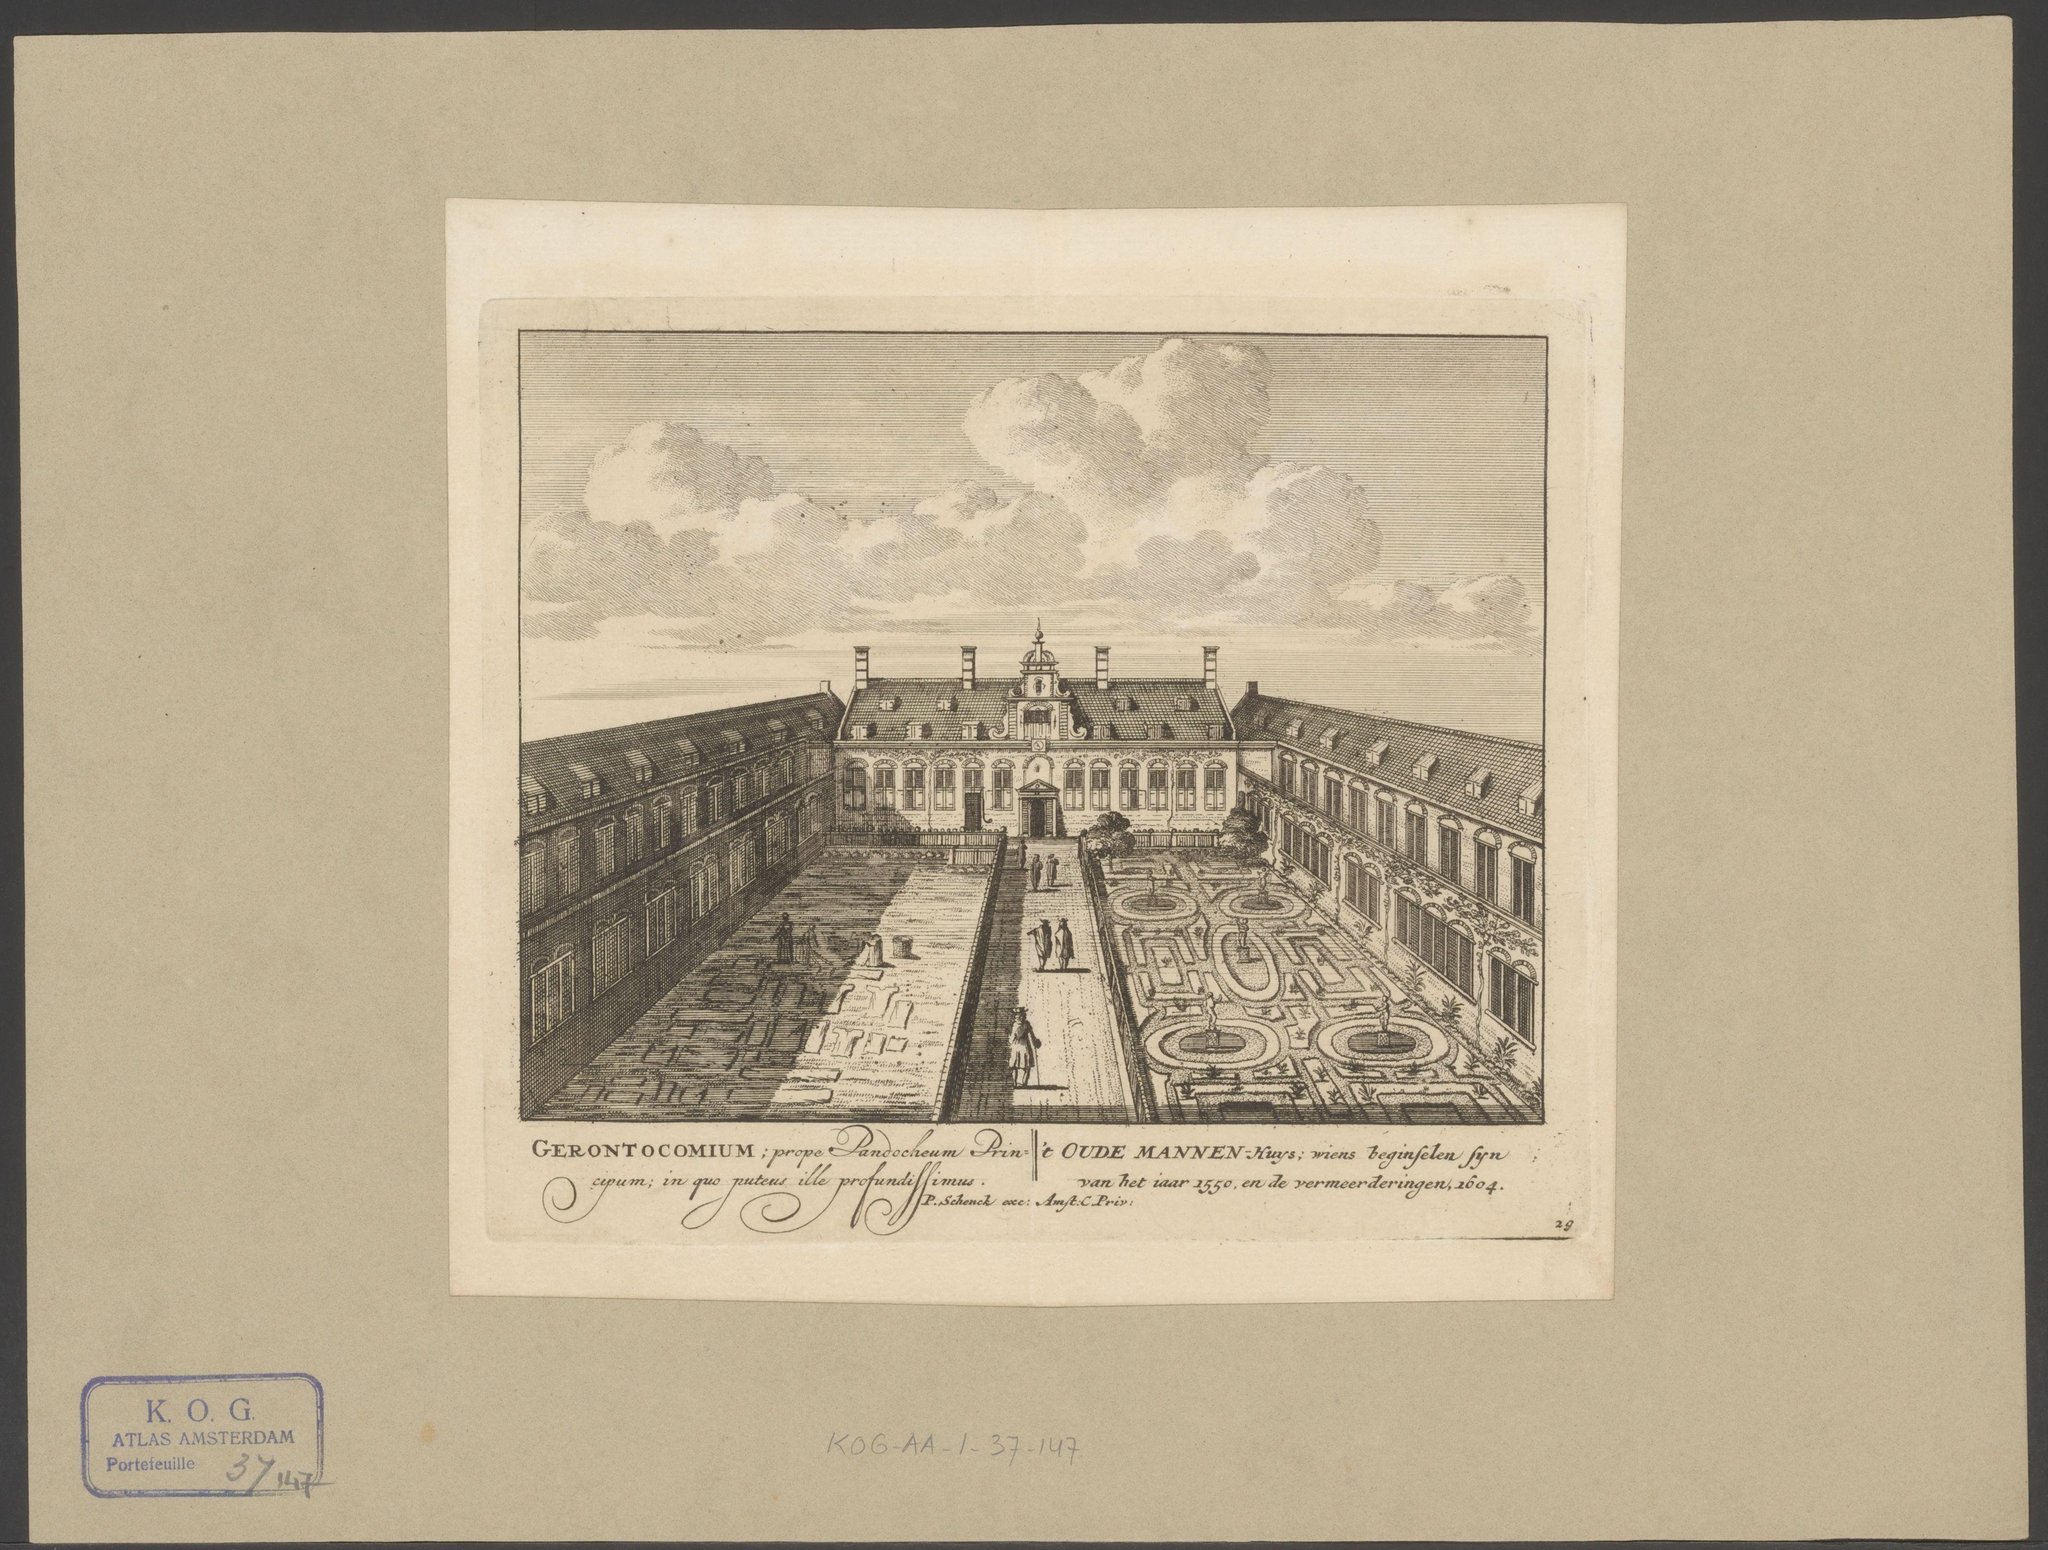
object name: print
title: Gerontocomium; prope Pandocheum Principum in quo putens ille profundissimus / 't Oude Mannen-Huys; wiens beginselen zyn van het jaar 1550, en de vermeerderingen 1604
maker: Anonymous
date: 1710-1711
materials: paper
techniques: engraving, etching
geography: northern netherlands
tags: courtyard, old-people's home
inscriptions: collector's mark: Lugt 1641b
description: Prent mogelijk uit: 100 Afbeeldinge der voornaamste gebouwen van Amsterdam. Amsterdam: Pieter Schenk (I), s.a. [1710-1711]. Of uit: 100 Afbeeldinge der voornaamste gebouwen van Amsterdam. Amsterdam: Barent Greve, s.a. [1757-1766]. In de tweede uitgave, uitgegeven door Barent Greve, is alleen de titelprent aangepast. De overige prenten zijn onveranderd gebleven.